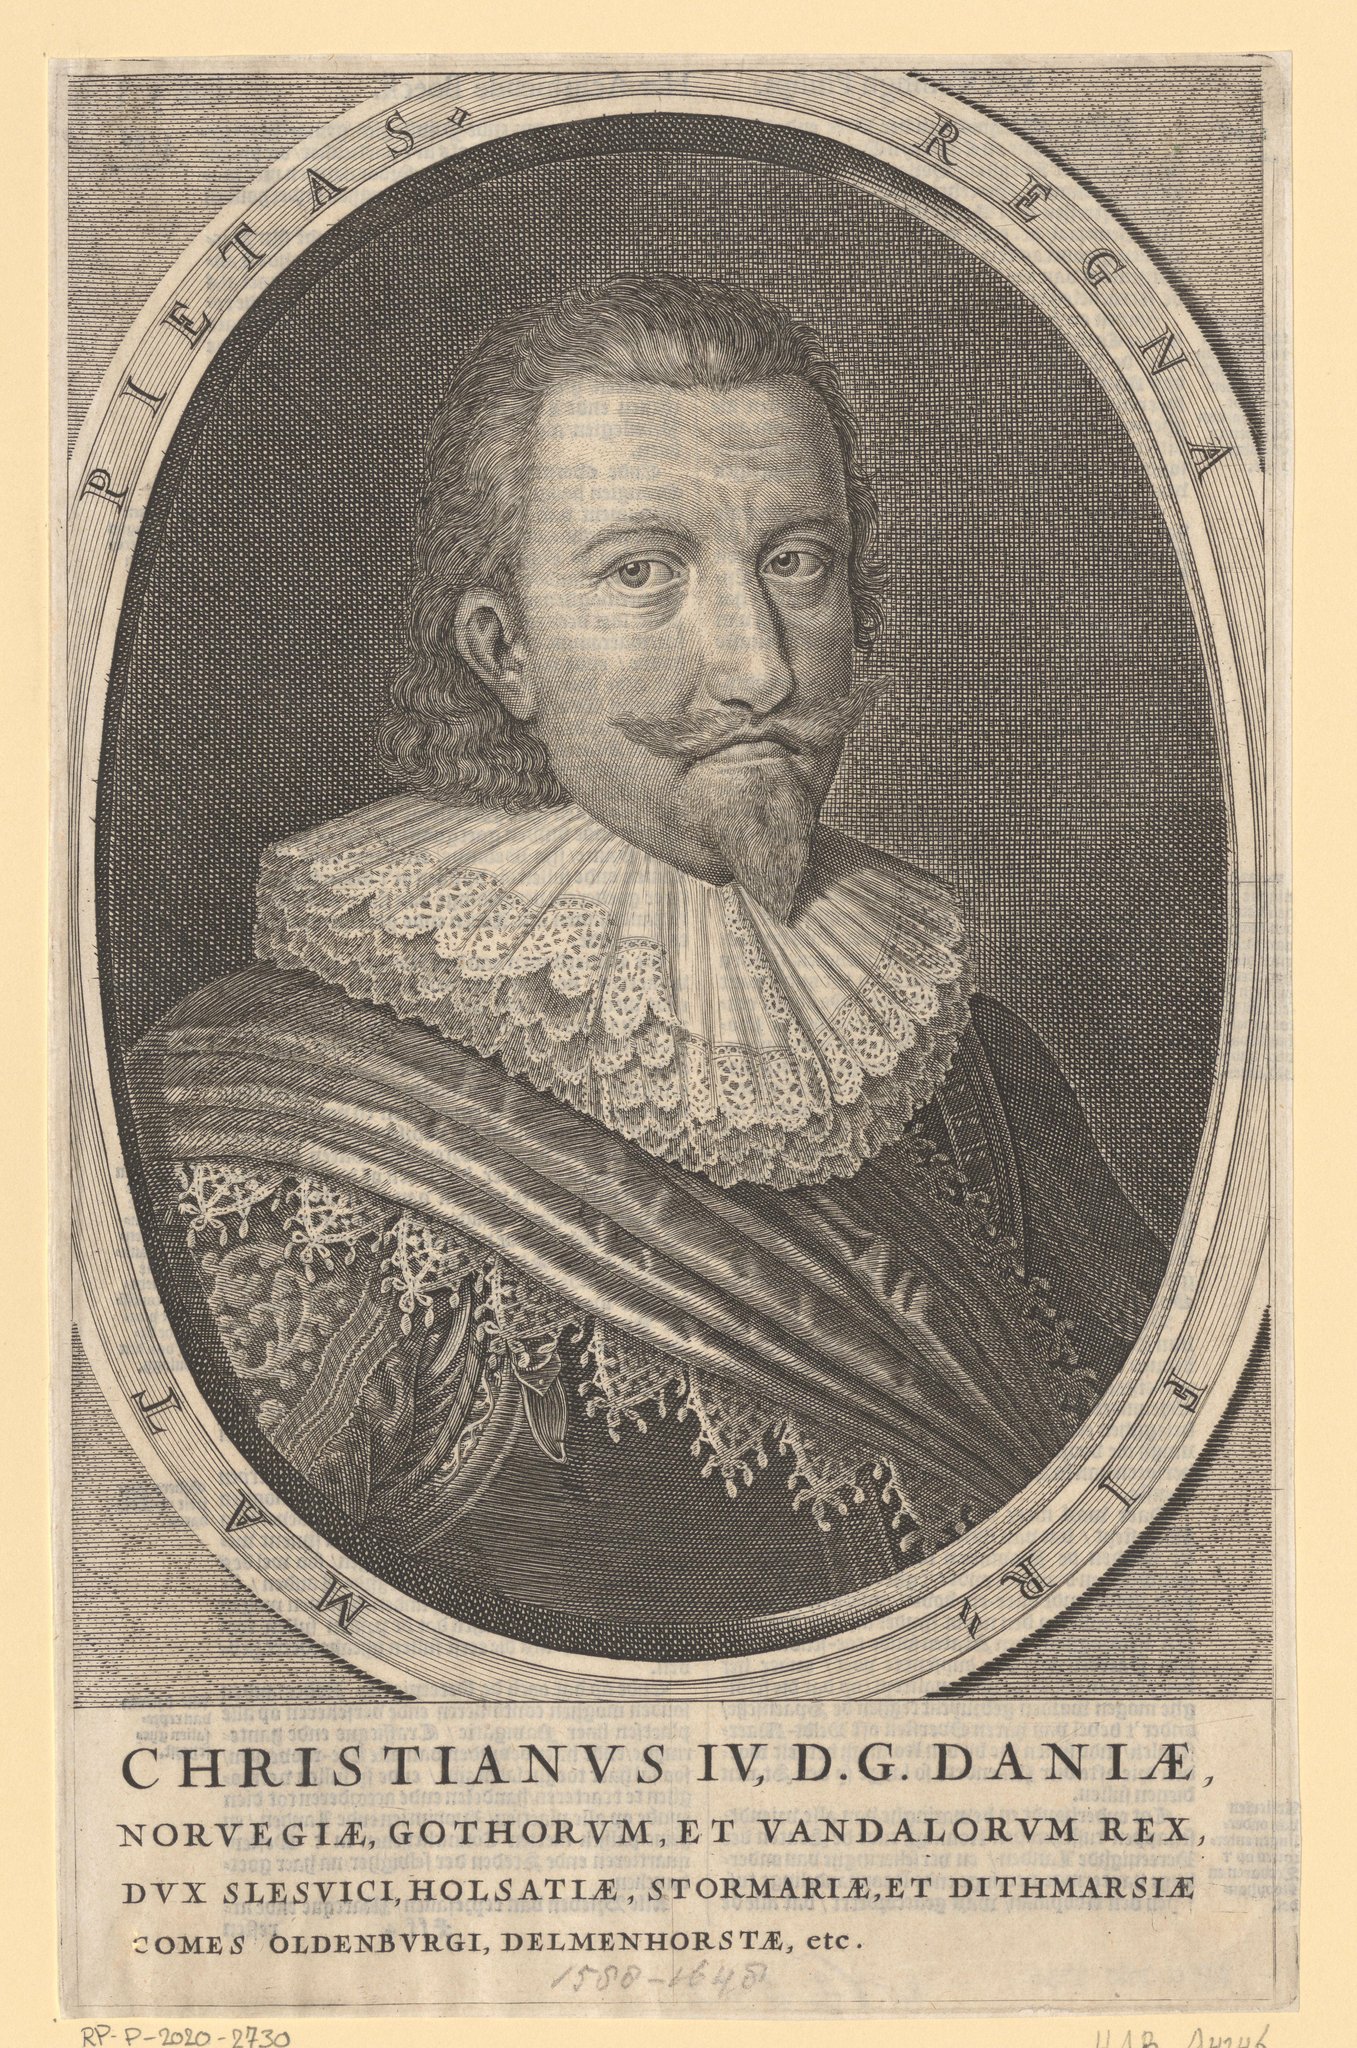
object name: print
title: Portret van Christiaan IV, koning van Denemarken en Noorwegen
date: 1652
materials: paper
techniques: engraving, letterpress printing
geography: amsterdam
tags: copenhagen (city), christiaan iv (koning van denemarken en noorwegen), historical persons, ruler, sovereign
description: Prent uit: Meteren, Emanuel van. Historien der Nederlanden, en haar naburen oorlogen. Amsterdam: Jan Jacobsz. Schipper, 1652, p. 348-349.